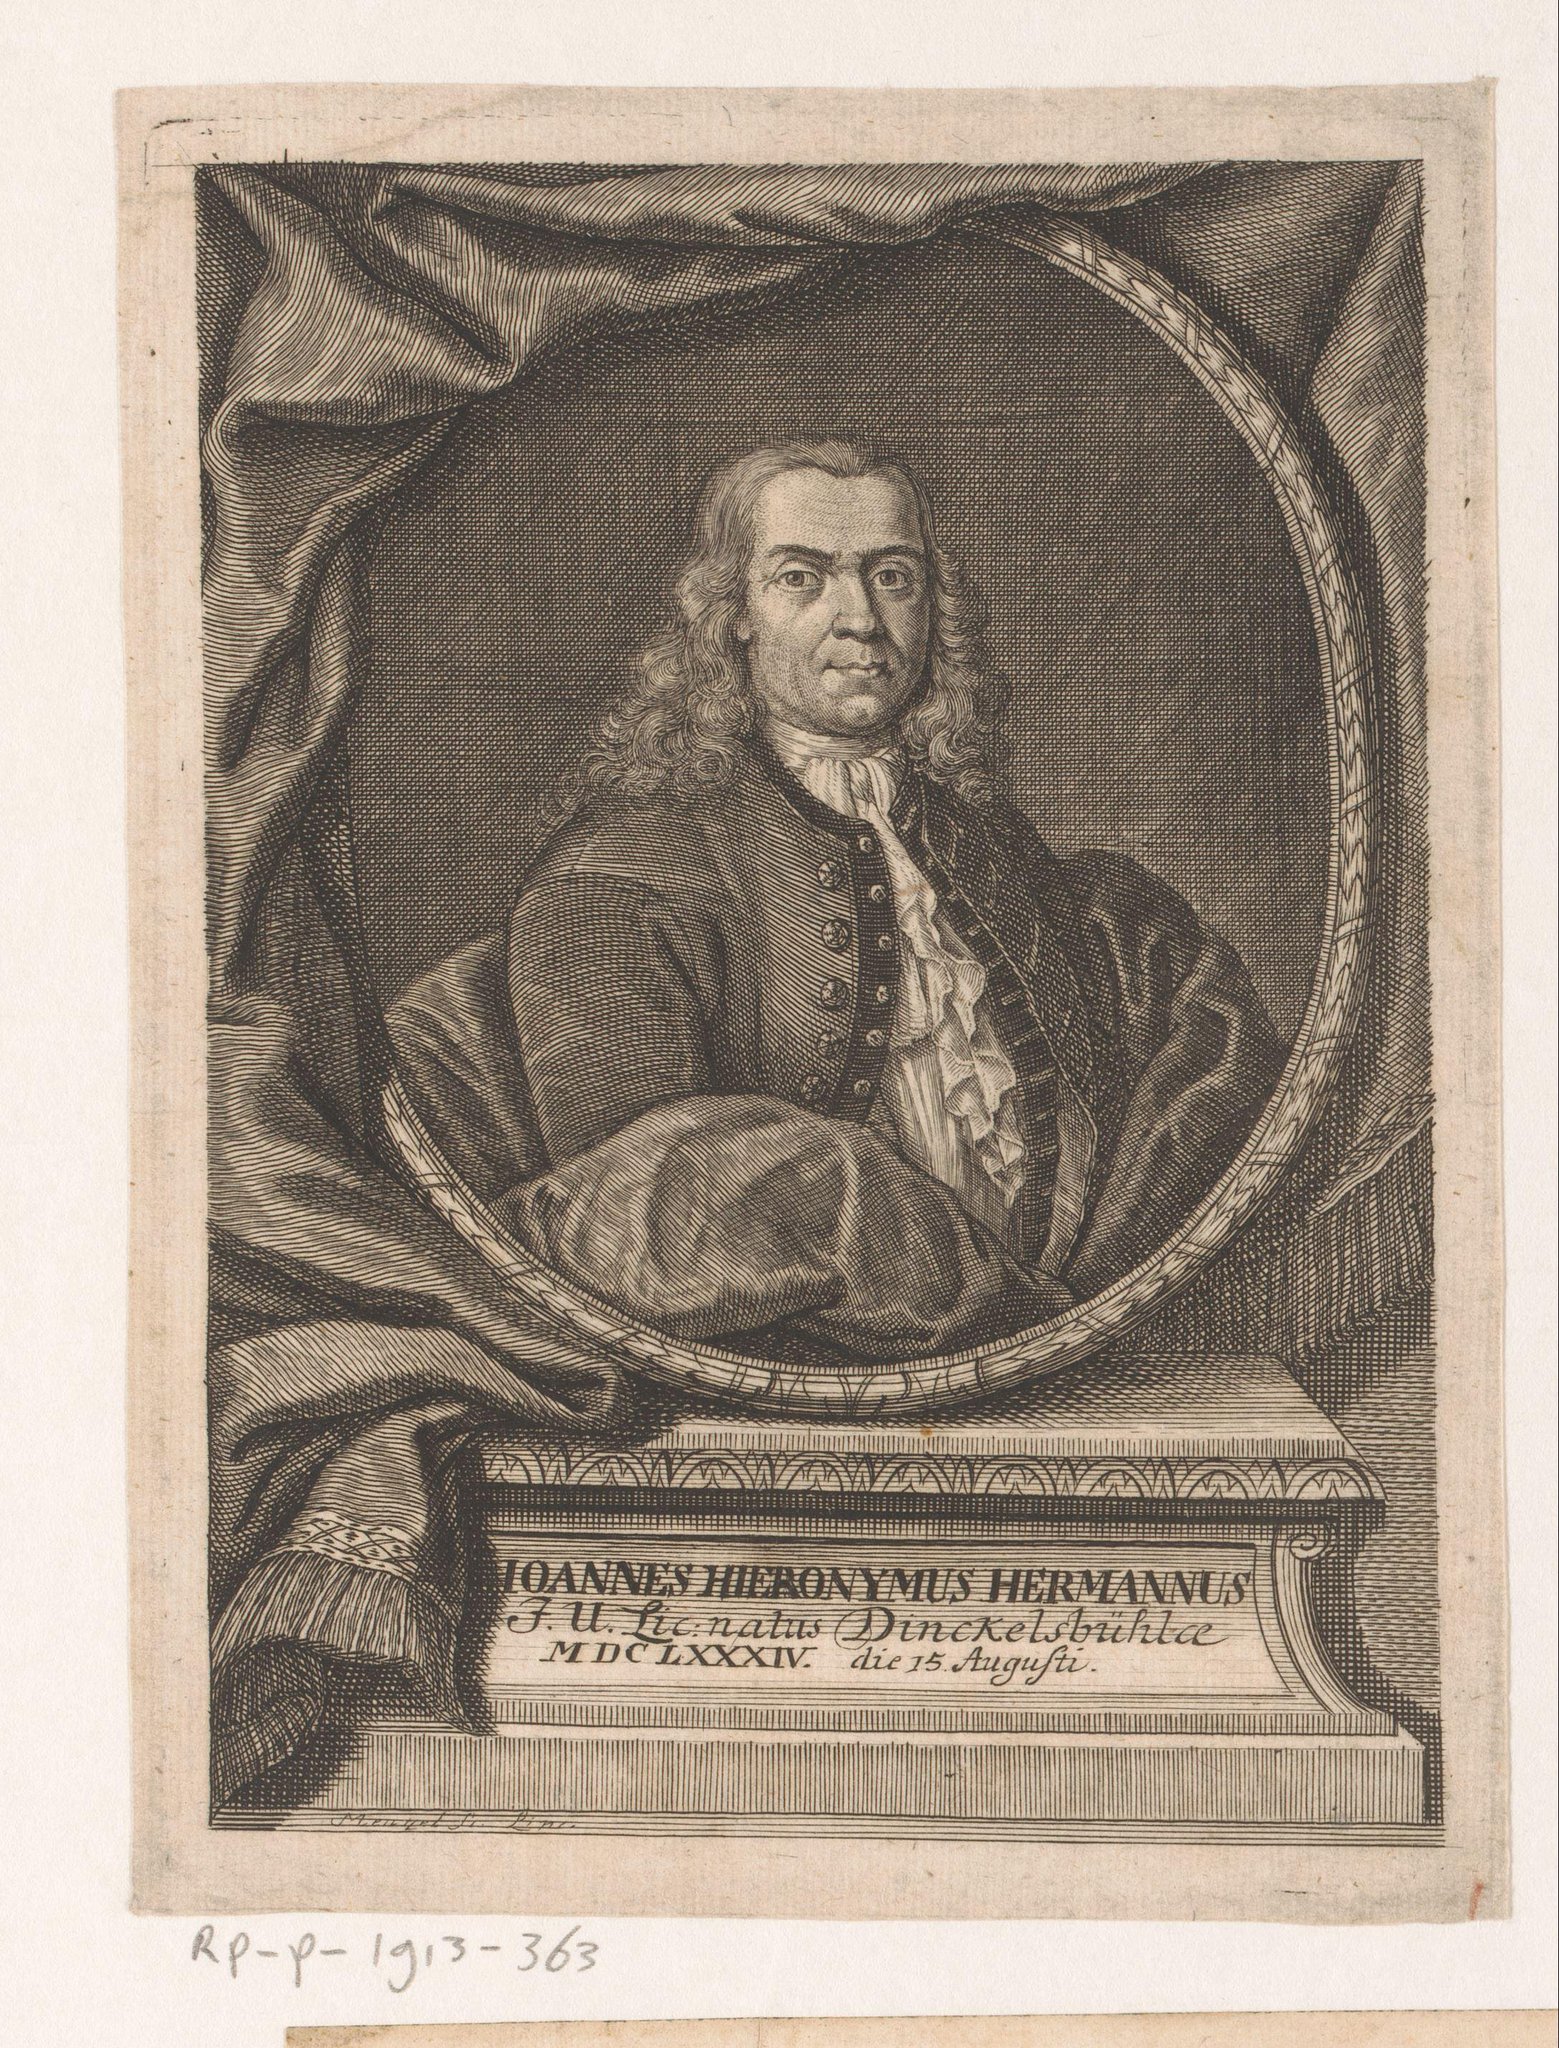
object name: print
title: Portret van Johann Hieronymus Hermann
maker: johann georg mentzel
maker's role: print maker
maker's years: 1677-1743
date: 1687-1743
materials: paper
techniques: engraving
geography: leipzig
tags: historical persons, wig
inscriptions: collector's mark: Lugt 2228